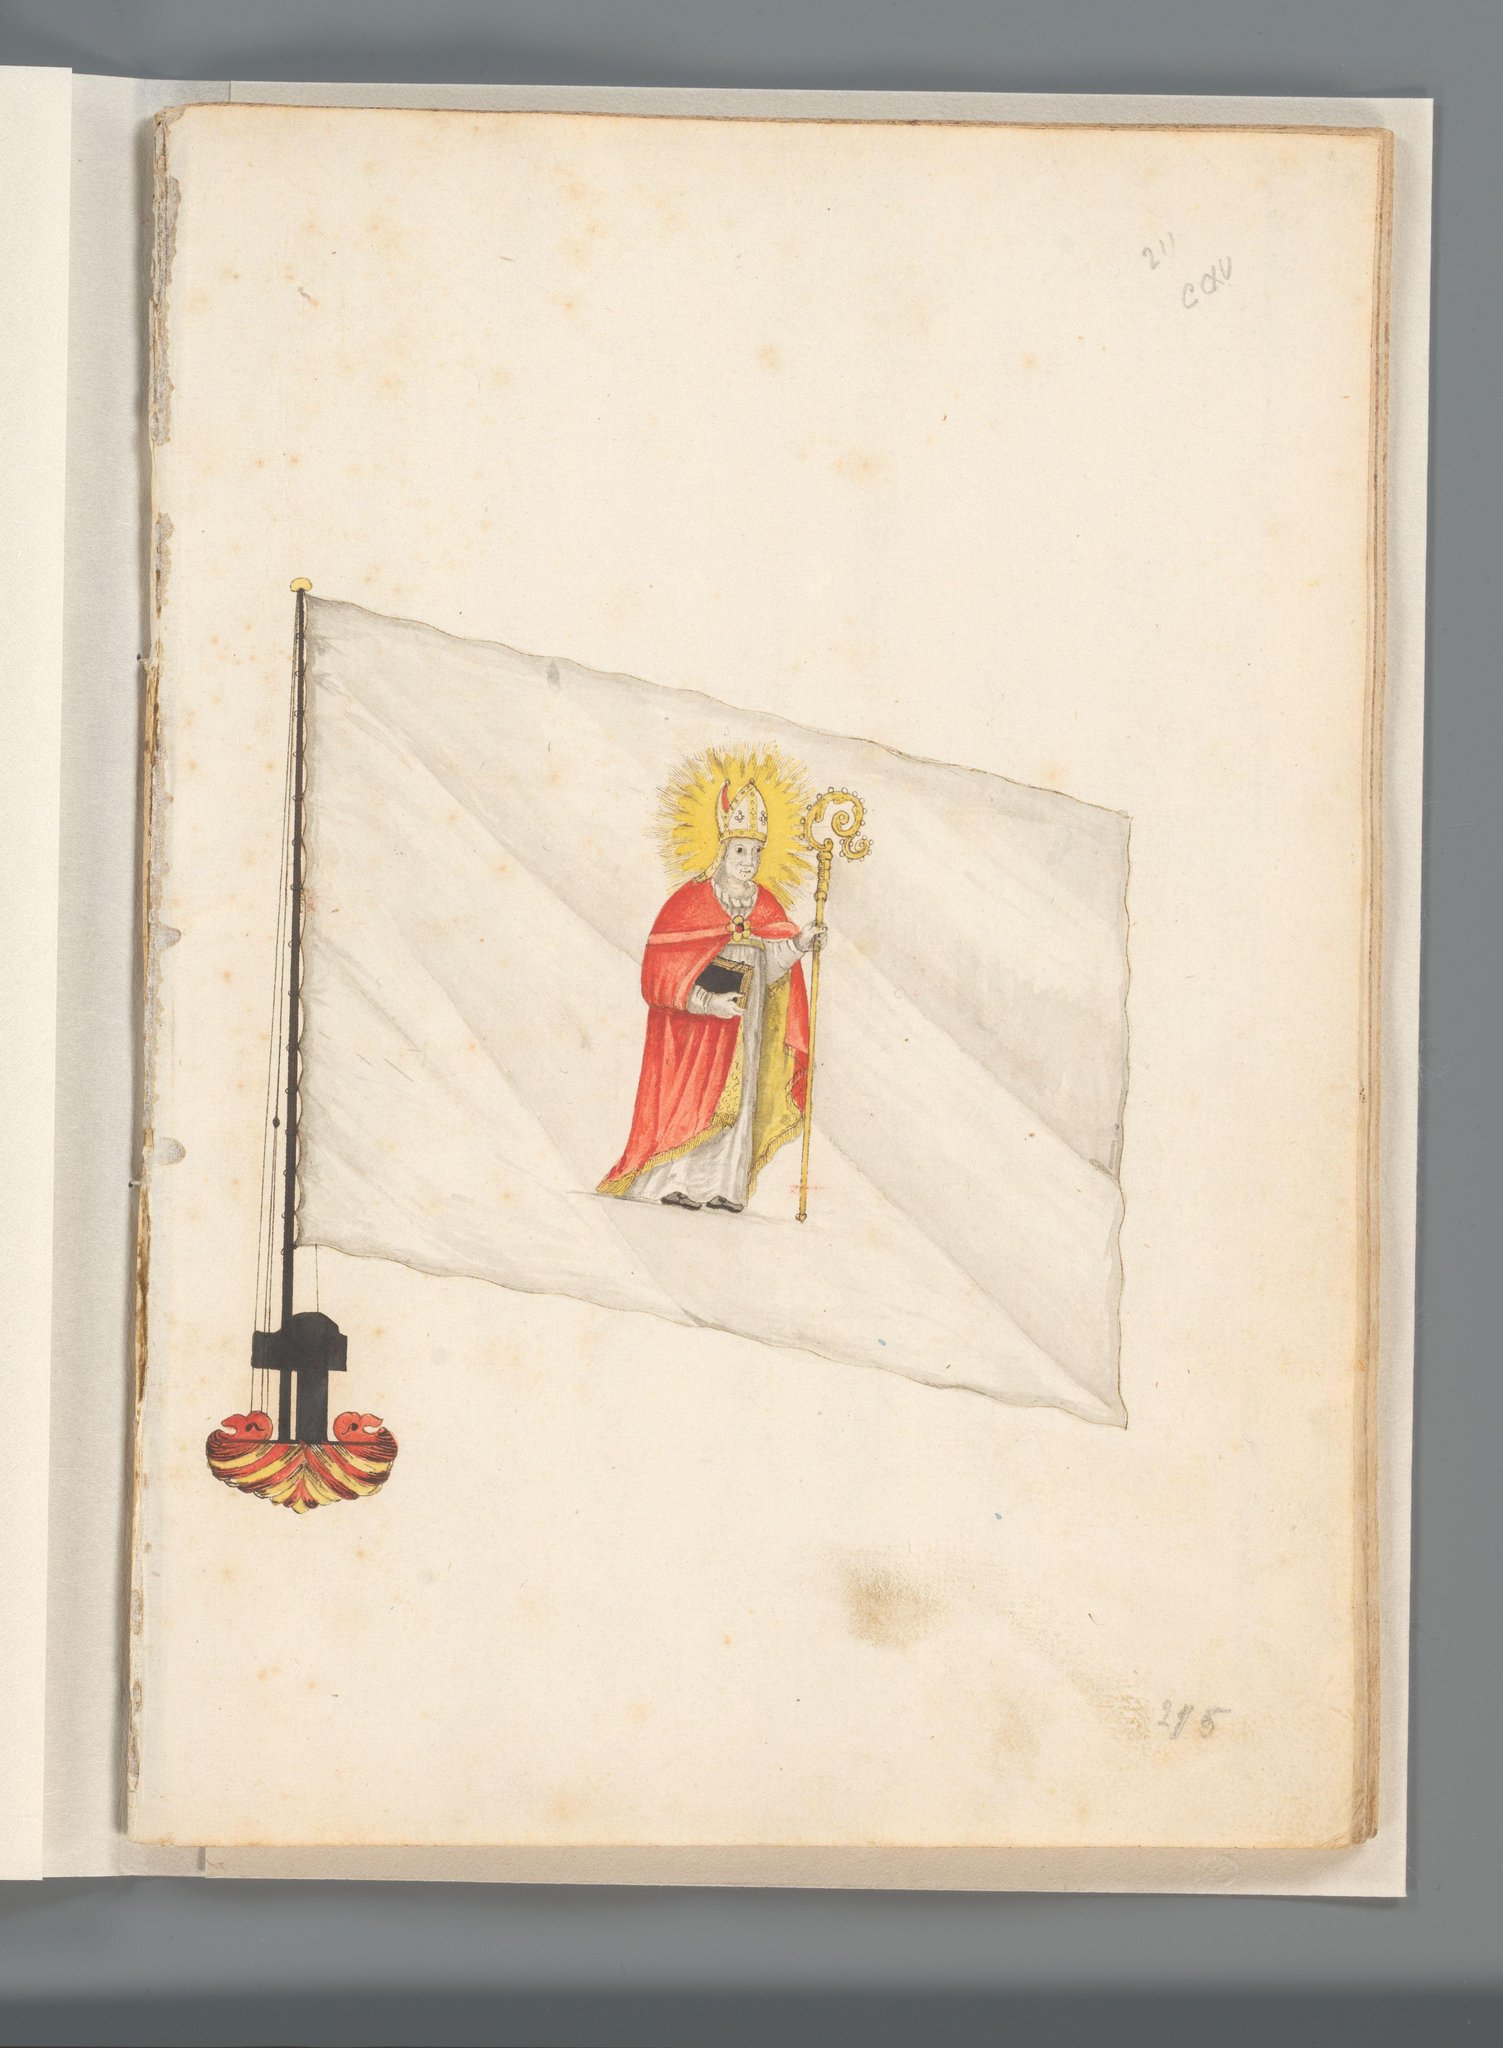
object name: drawing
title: Vlag van Ragusa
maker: Anonymous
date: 1667-1670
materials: ink, paper, watercolor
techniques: brush, pen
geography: france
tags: flag, colours (as symbol of the state, etc.)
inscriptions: number: ‘211 / CCXV / 215’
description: Vlag van de stad Ragusa (Dubrovnik). Witte vlag waarop de figuur van de heilige Blasius van Sebaste. Vlag op vlaggensteng en mastvoet. Afgebeeld op folio 108r. Onderdeel van een vlaggenboek met vlaggen uit Europa, Noord-Afrika, Nabije en Verre Oosten.